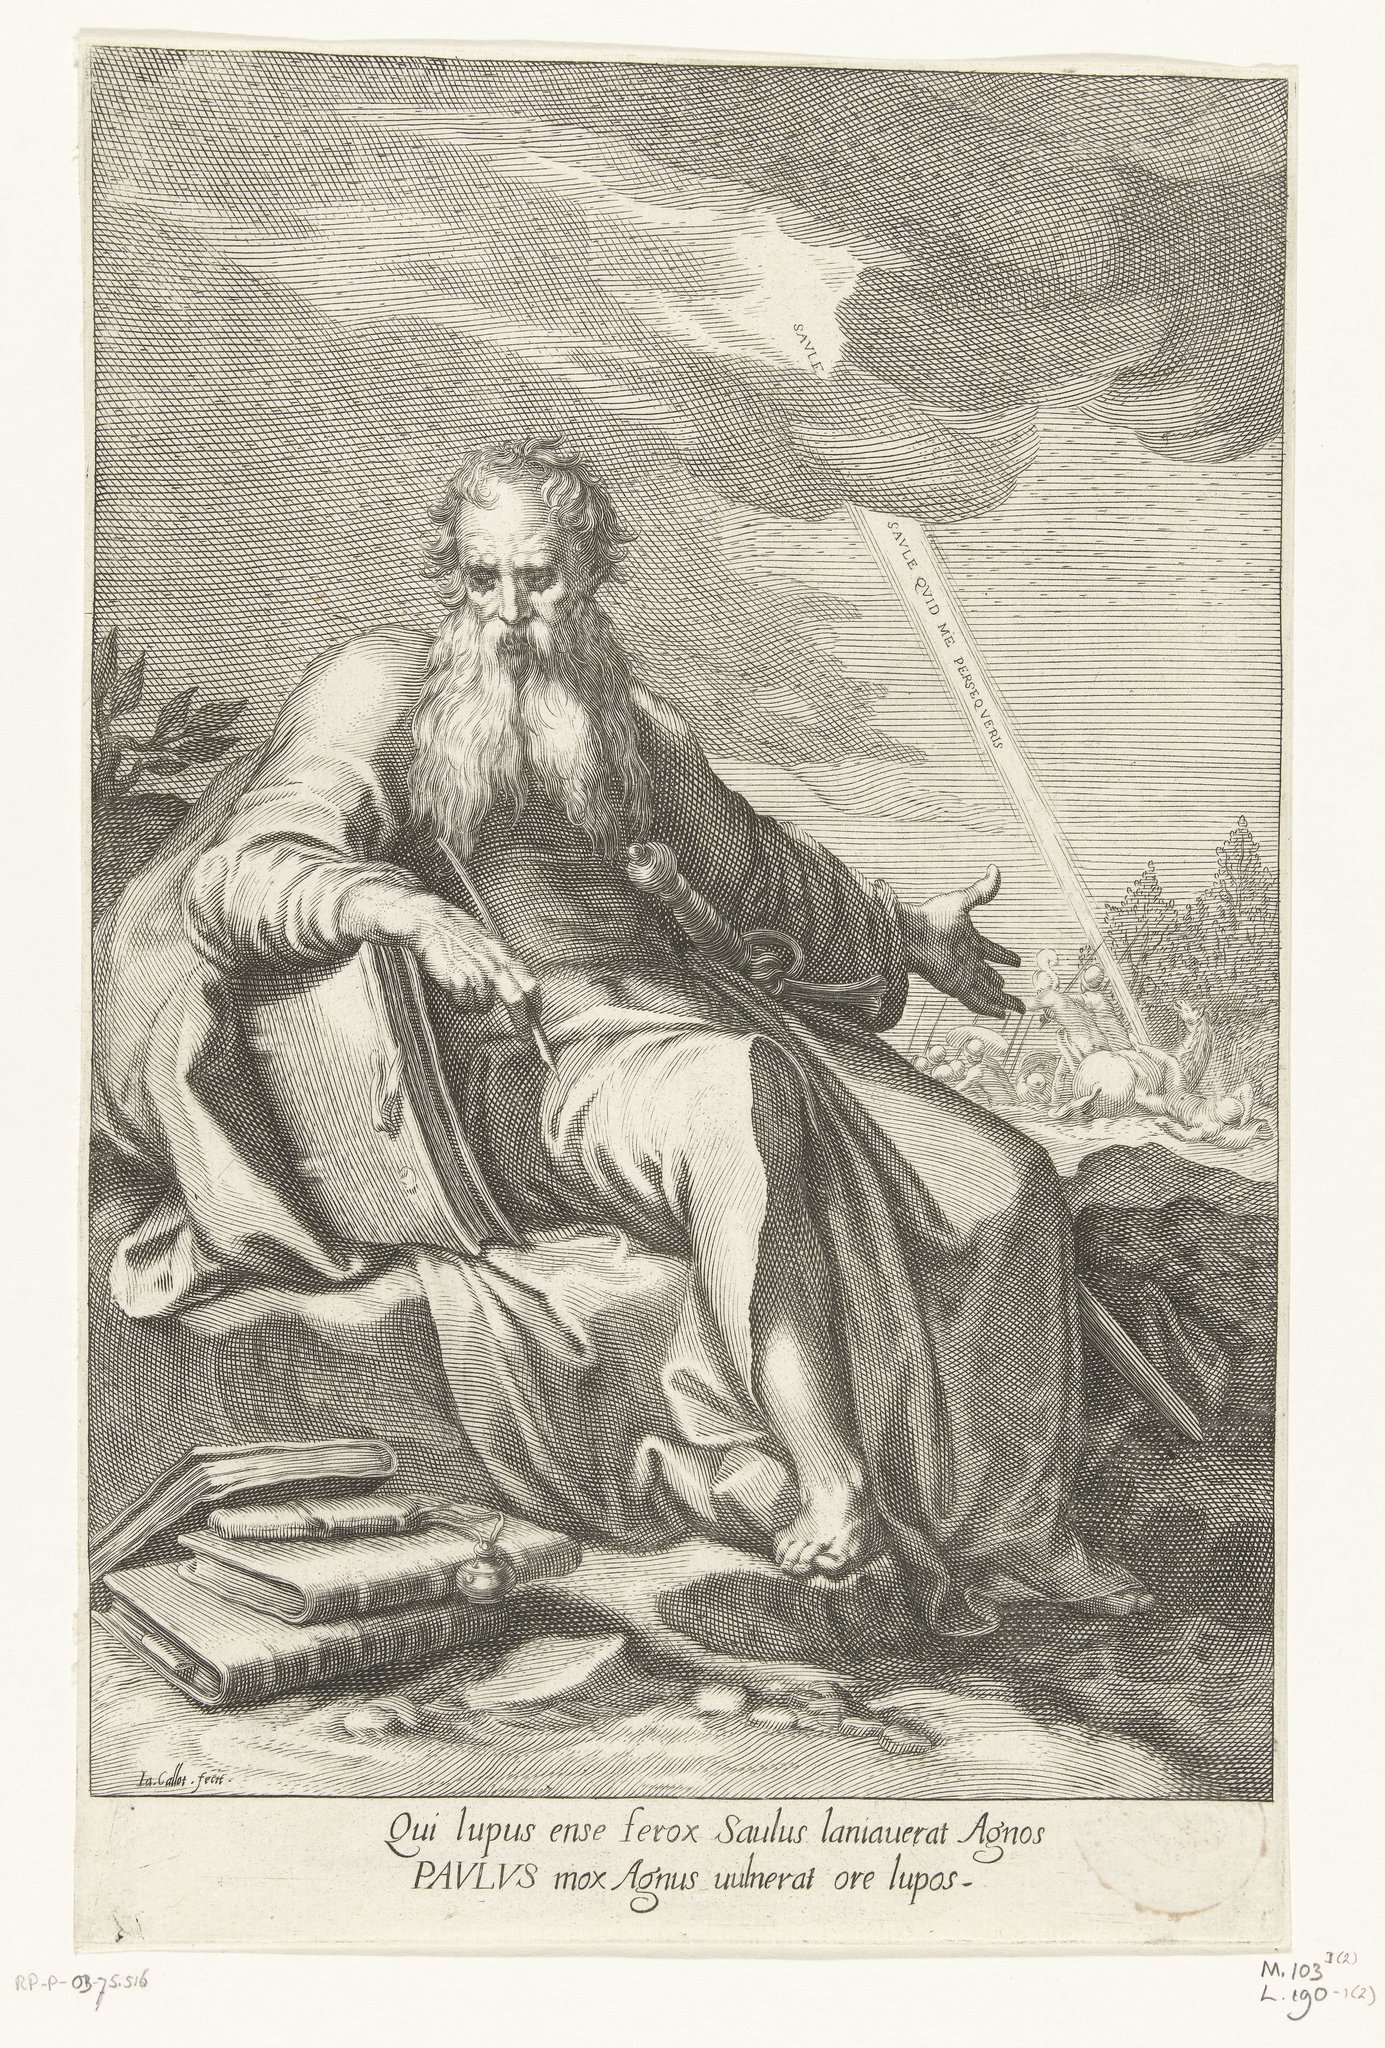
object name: print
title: Heilige Paulus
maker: jacques callot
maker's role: draughtsman, print maker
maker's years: 1592-1635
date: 1611-1622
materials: paper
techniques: engraving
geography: florence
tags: on the way to damascus christ appears to saul, who falls from his horse and is blinded by the light, the apostle paul of tarsus; possible attributes: book, scroll, sword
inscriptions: collector's mark: Lugt 240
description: De Heilige Paulus zit op een rots, omringd door boeken. Op de achtergrond is het verhaal van zijn bekering te zien: hoe hij onderweg naar Damascus getroffen door een groot licht en een stem uit de hemel van zijn paard viel. onder de voorstelling een onderschrift in Latijn.